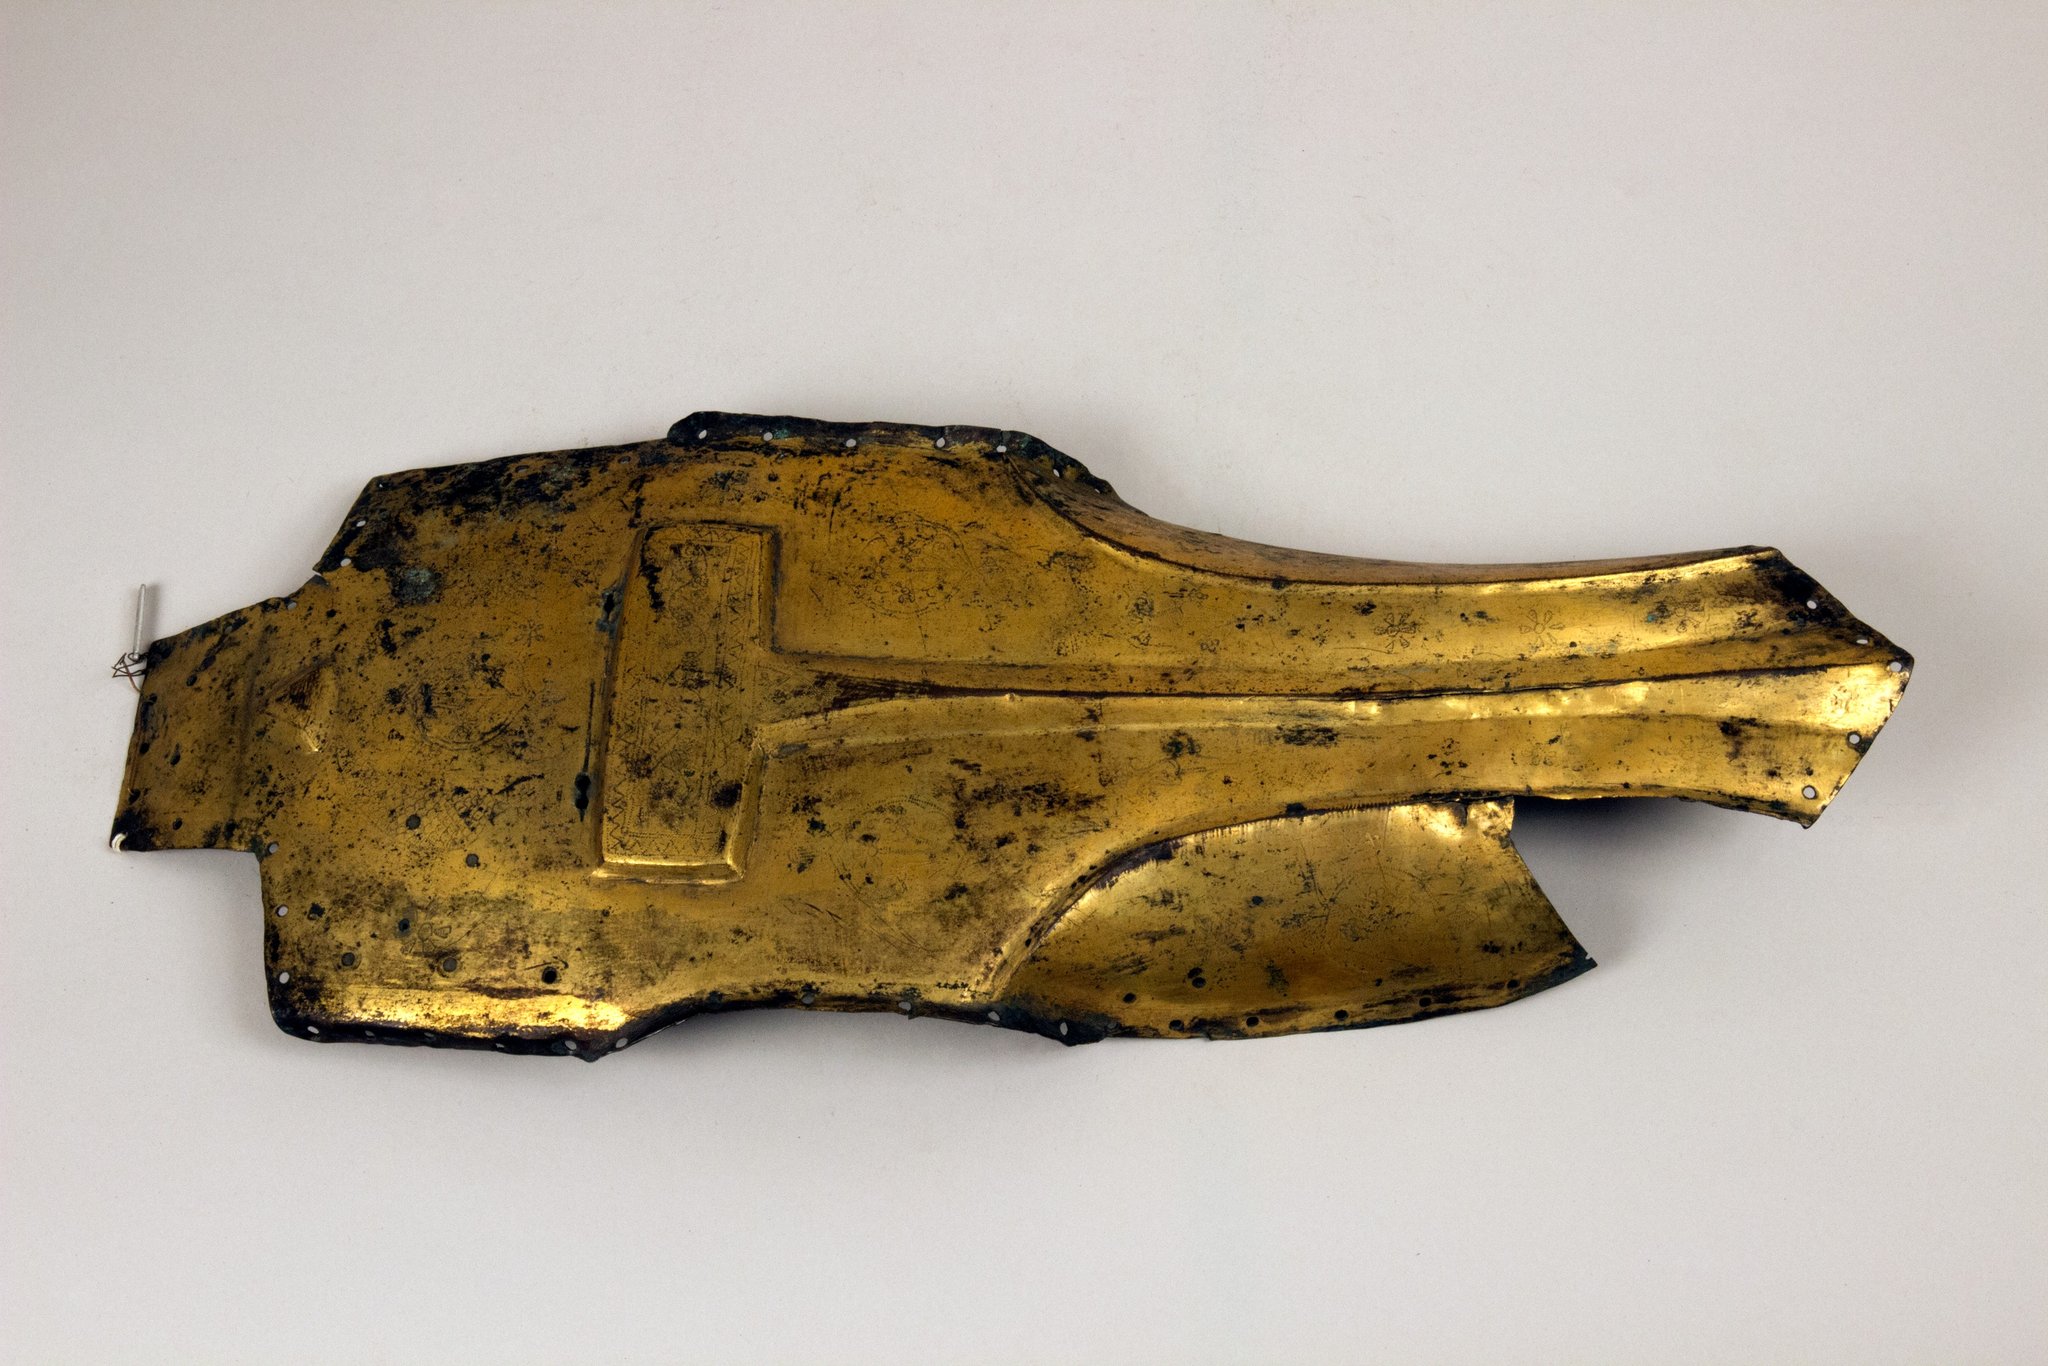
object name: shaffron horse's head defense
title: Shaffron (Horse's Head Defense)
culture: turkish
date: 1401-1500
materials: copper, gold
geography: ottoman empire